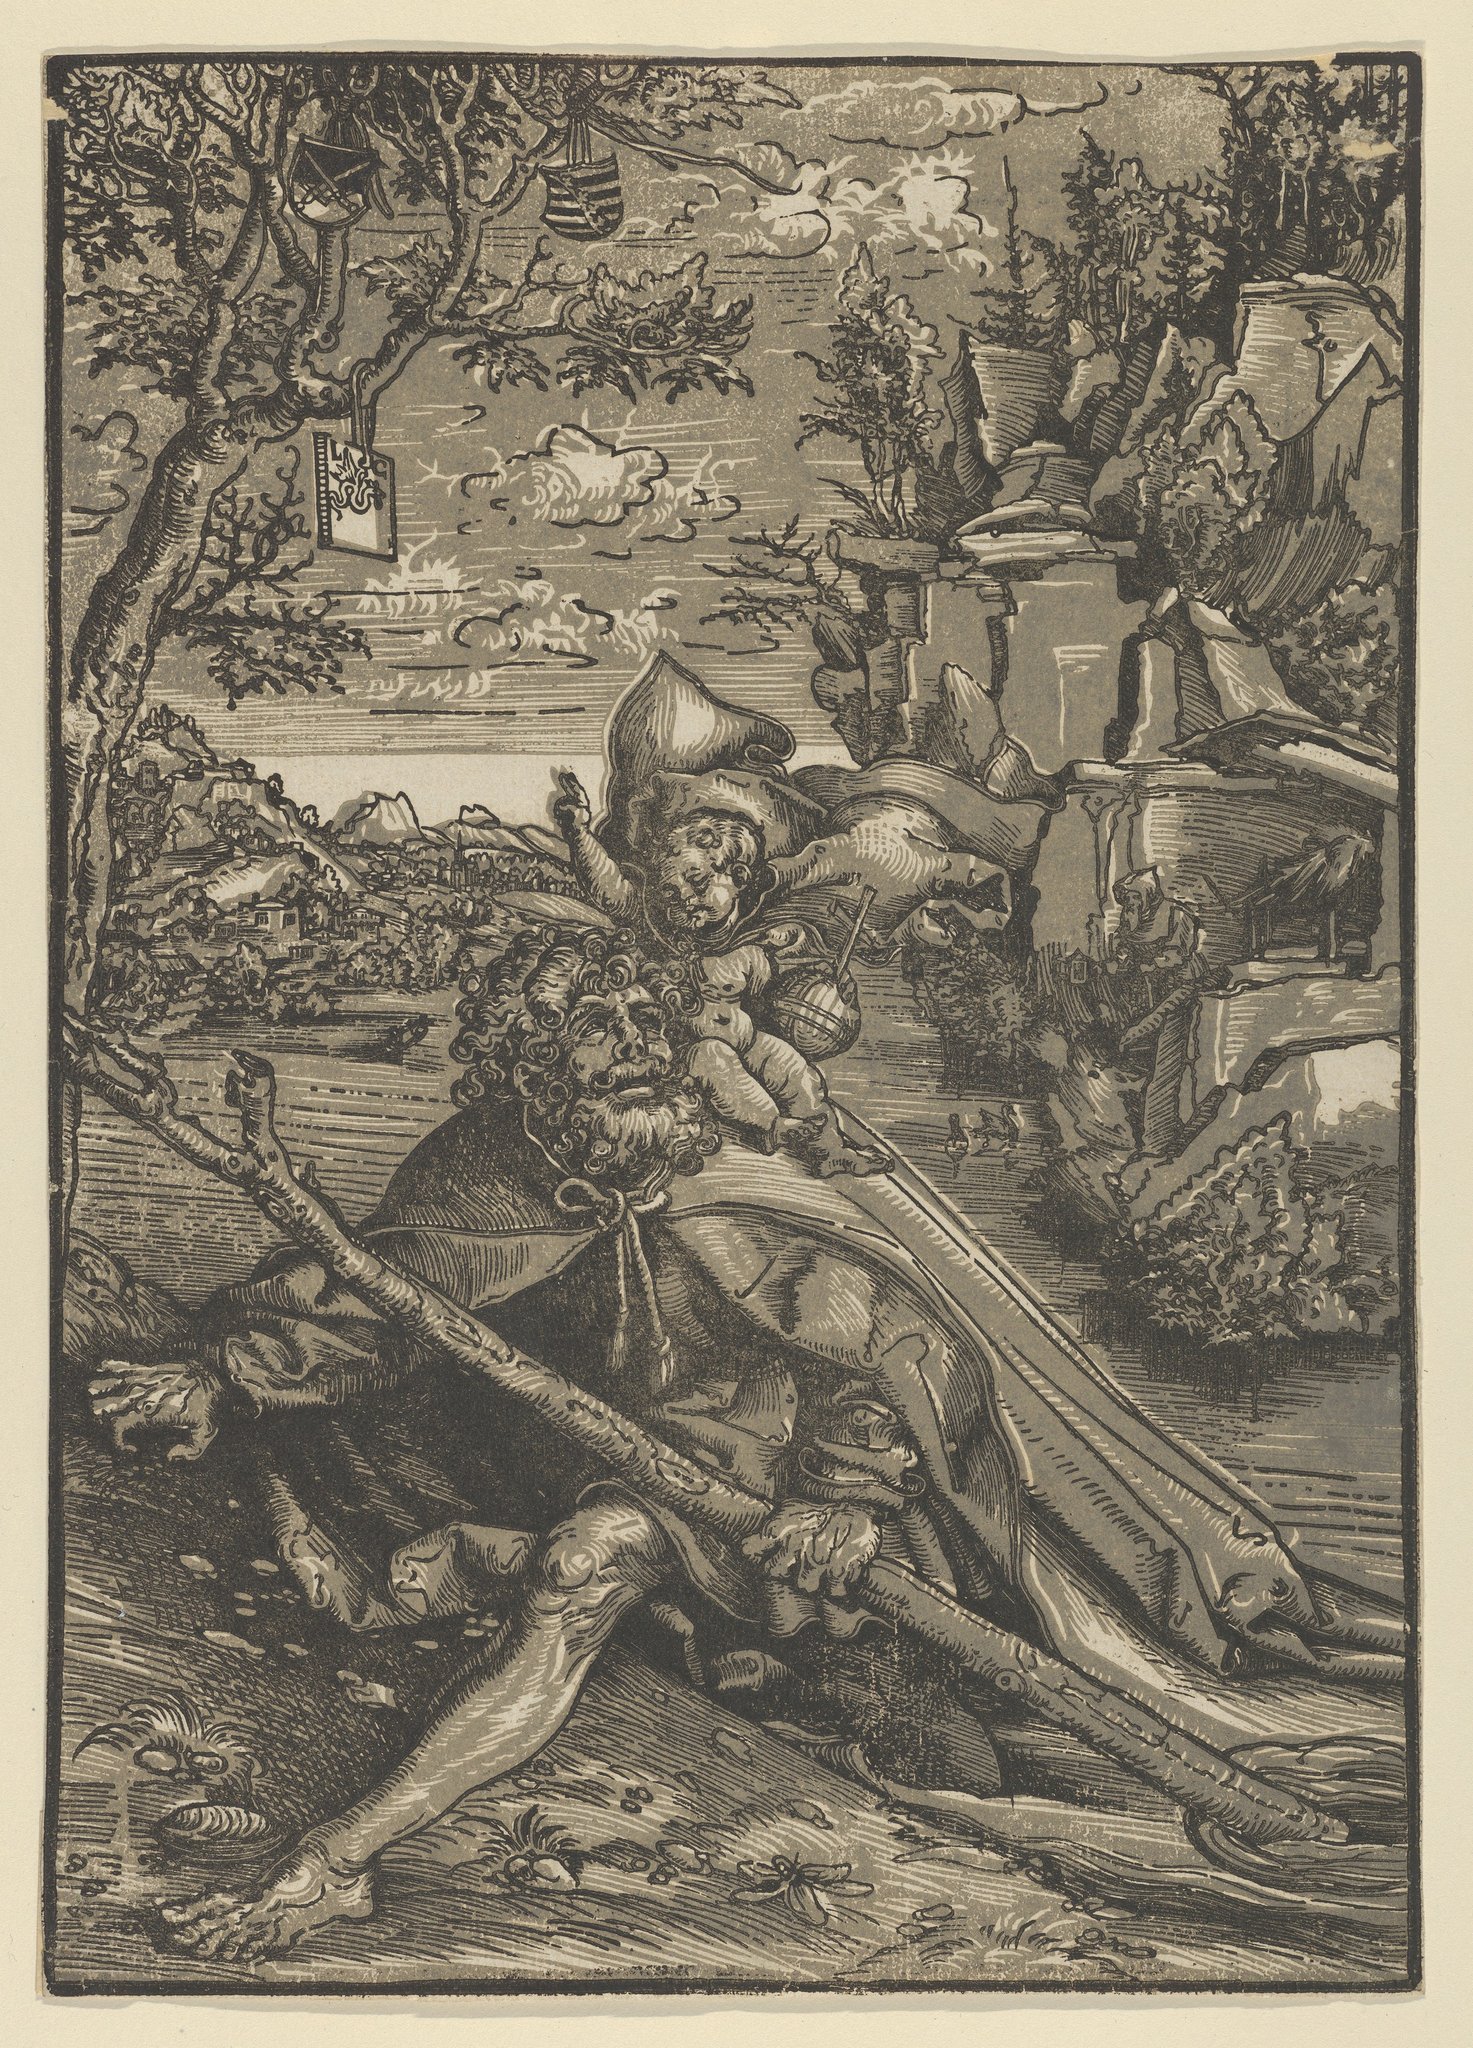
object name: print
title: Saint Christopher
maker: lucas cranach the elder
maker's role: artist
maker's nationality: german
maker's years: 1472-1553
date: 1506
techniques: woodcut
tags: saint christopher